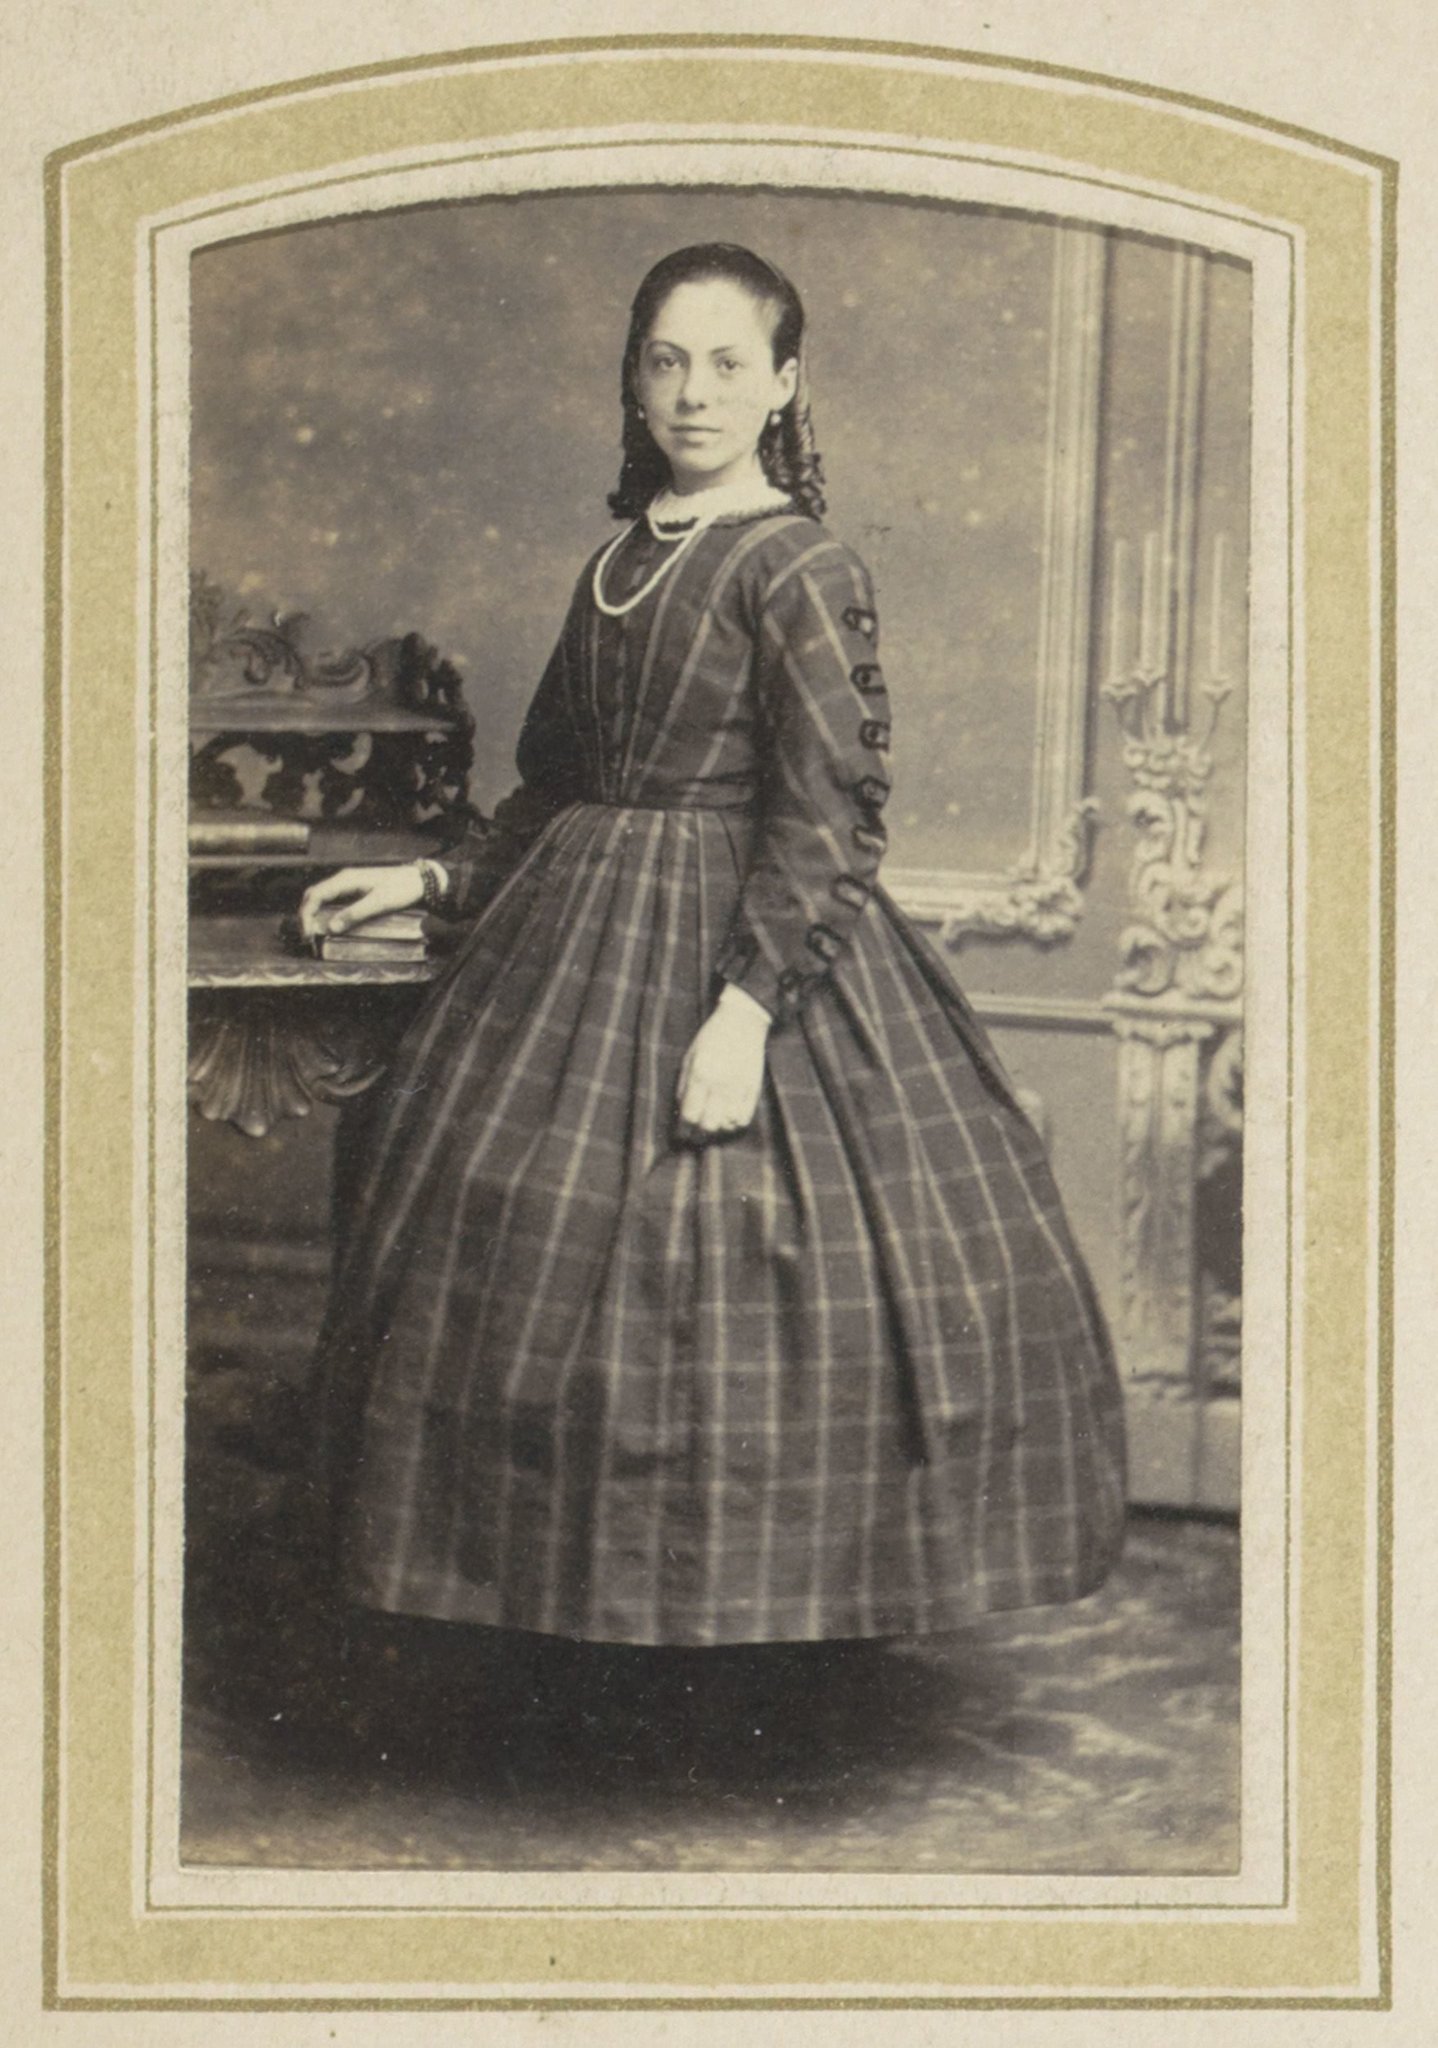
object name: photograph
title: Portret van een meisje in een geruite jurk bij een tafel met boeken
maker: a. böeseken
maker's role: fotograaf, lithograaf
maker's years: 1834-1919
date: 1865-1869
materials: cardboard, paper, photographic support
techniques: albumen print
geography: rotterdam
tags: studio requisites ~ photographer, historical persons, styles of hairdress - aa - ~ women, book, dress, gown, rotterdam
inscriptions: address: ‘Hoogstraat over de Vlasmarkt’, address: ‘Rotterdam’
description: Onderdeel van Fotoalbum van een Nederlandse familie met 168 cartes-de-visite en kabinetfoto's.